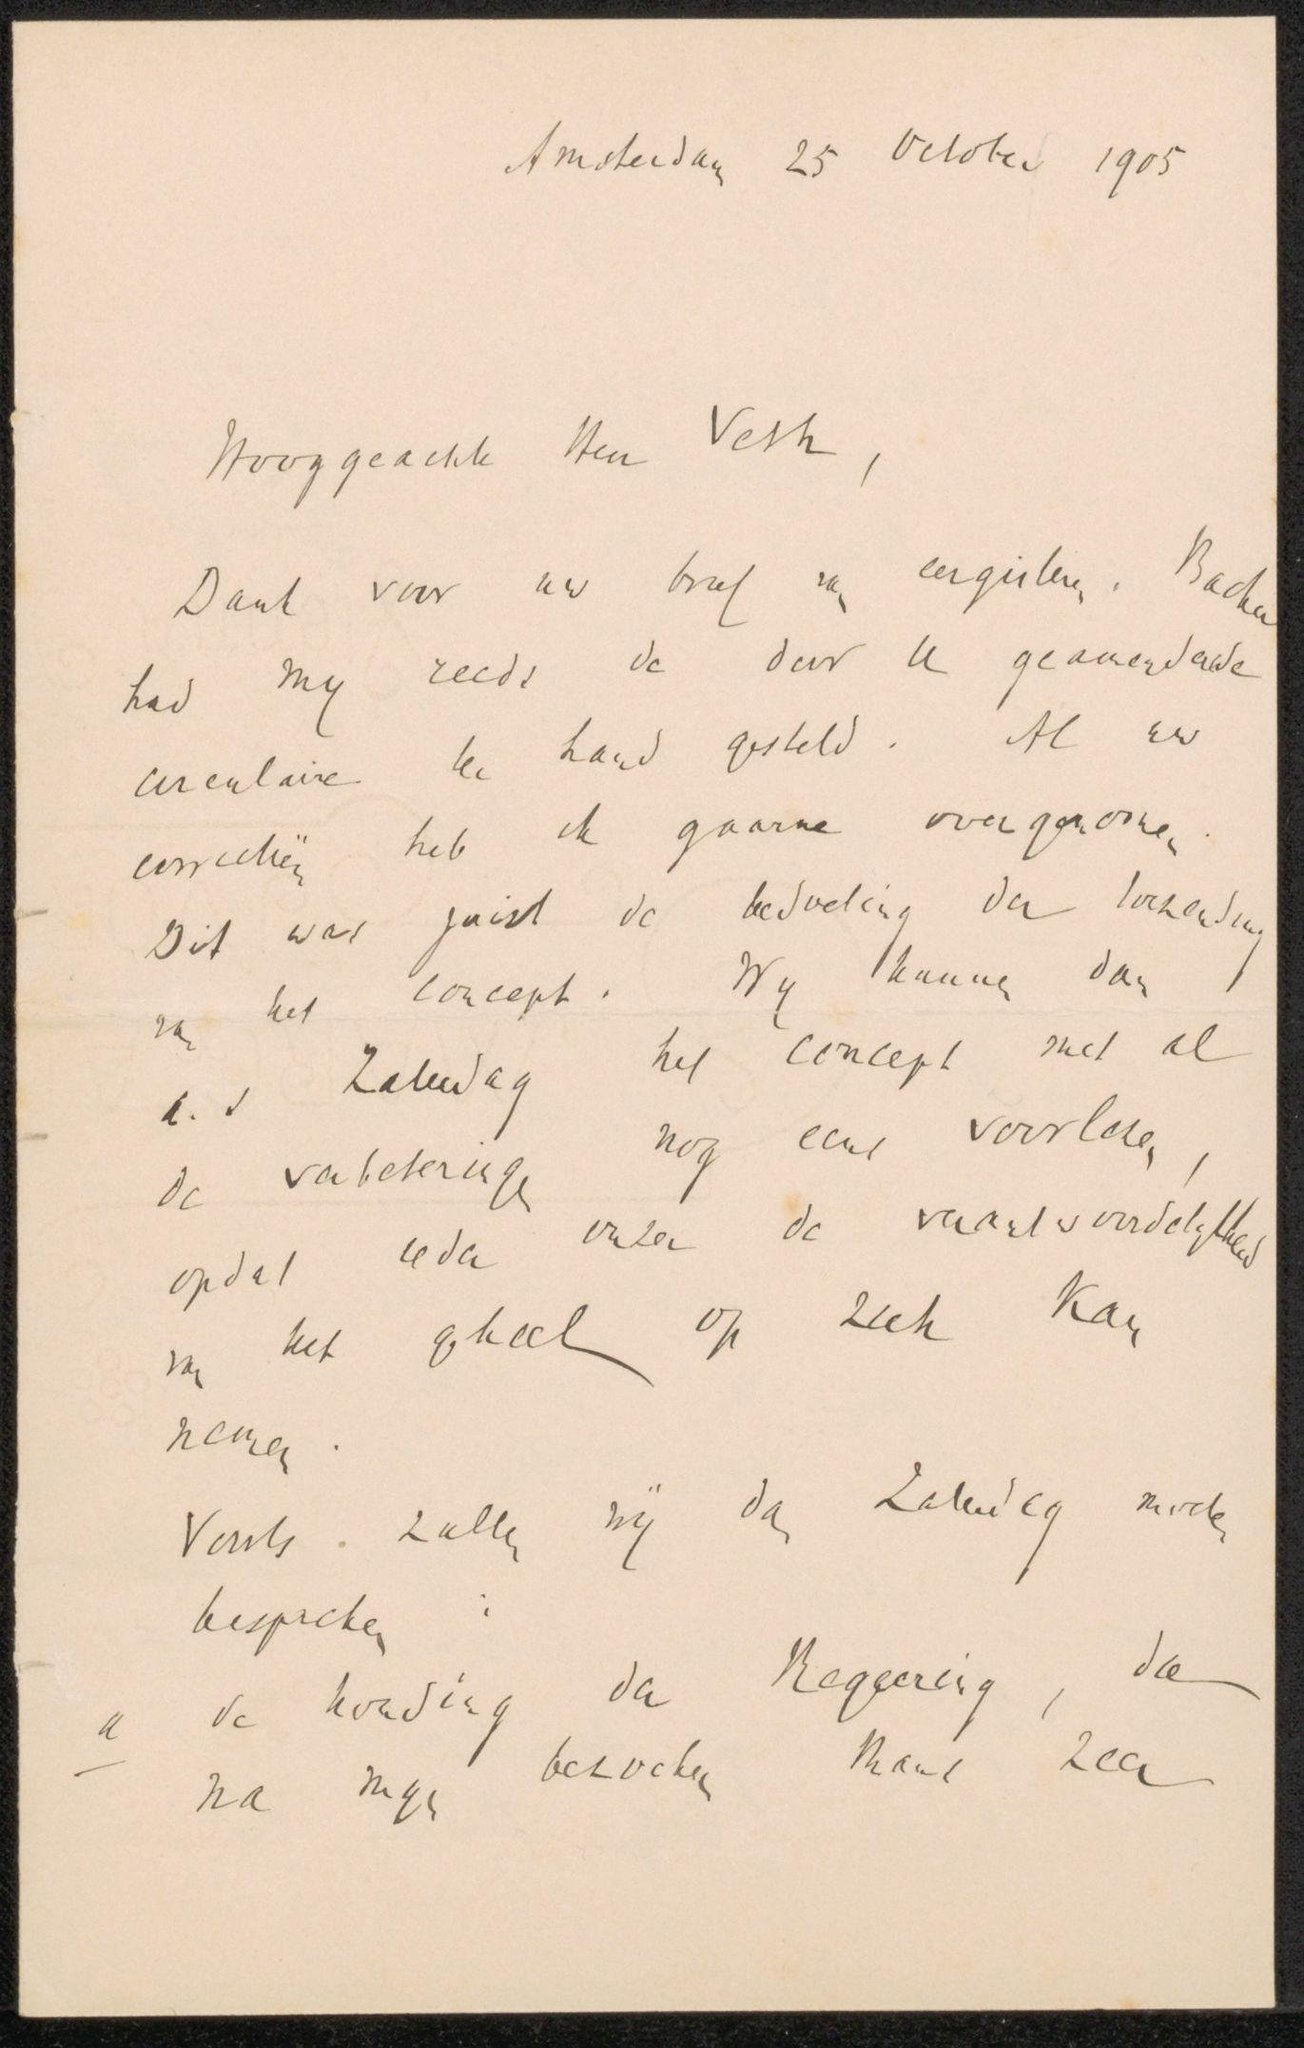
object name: letter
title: Brief aan Jan Veth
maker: hendrick peter godfried quack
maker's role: econoom, geschiedschrijver, hoogleraar, jurist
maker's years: 1834-1917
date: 1905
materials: ink, paper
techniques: pen, writing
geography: amsterdam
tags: the hague, jozef israëls, painter, léon bonnat, dordrecht, designer, jan veth, carel lodewijk dake, leiden, amsterdam, print maker, draughtsman, rembrandt van rijn, alphons diepenbrock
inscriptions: collector's mark: ‘RPK’